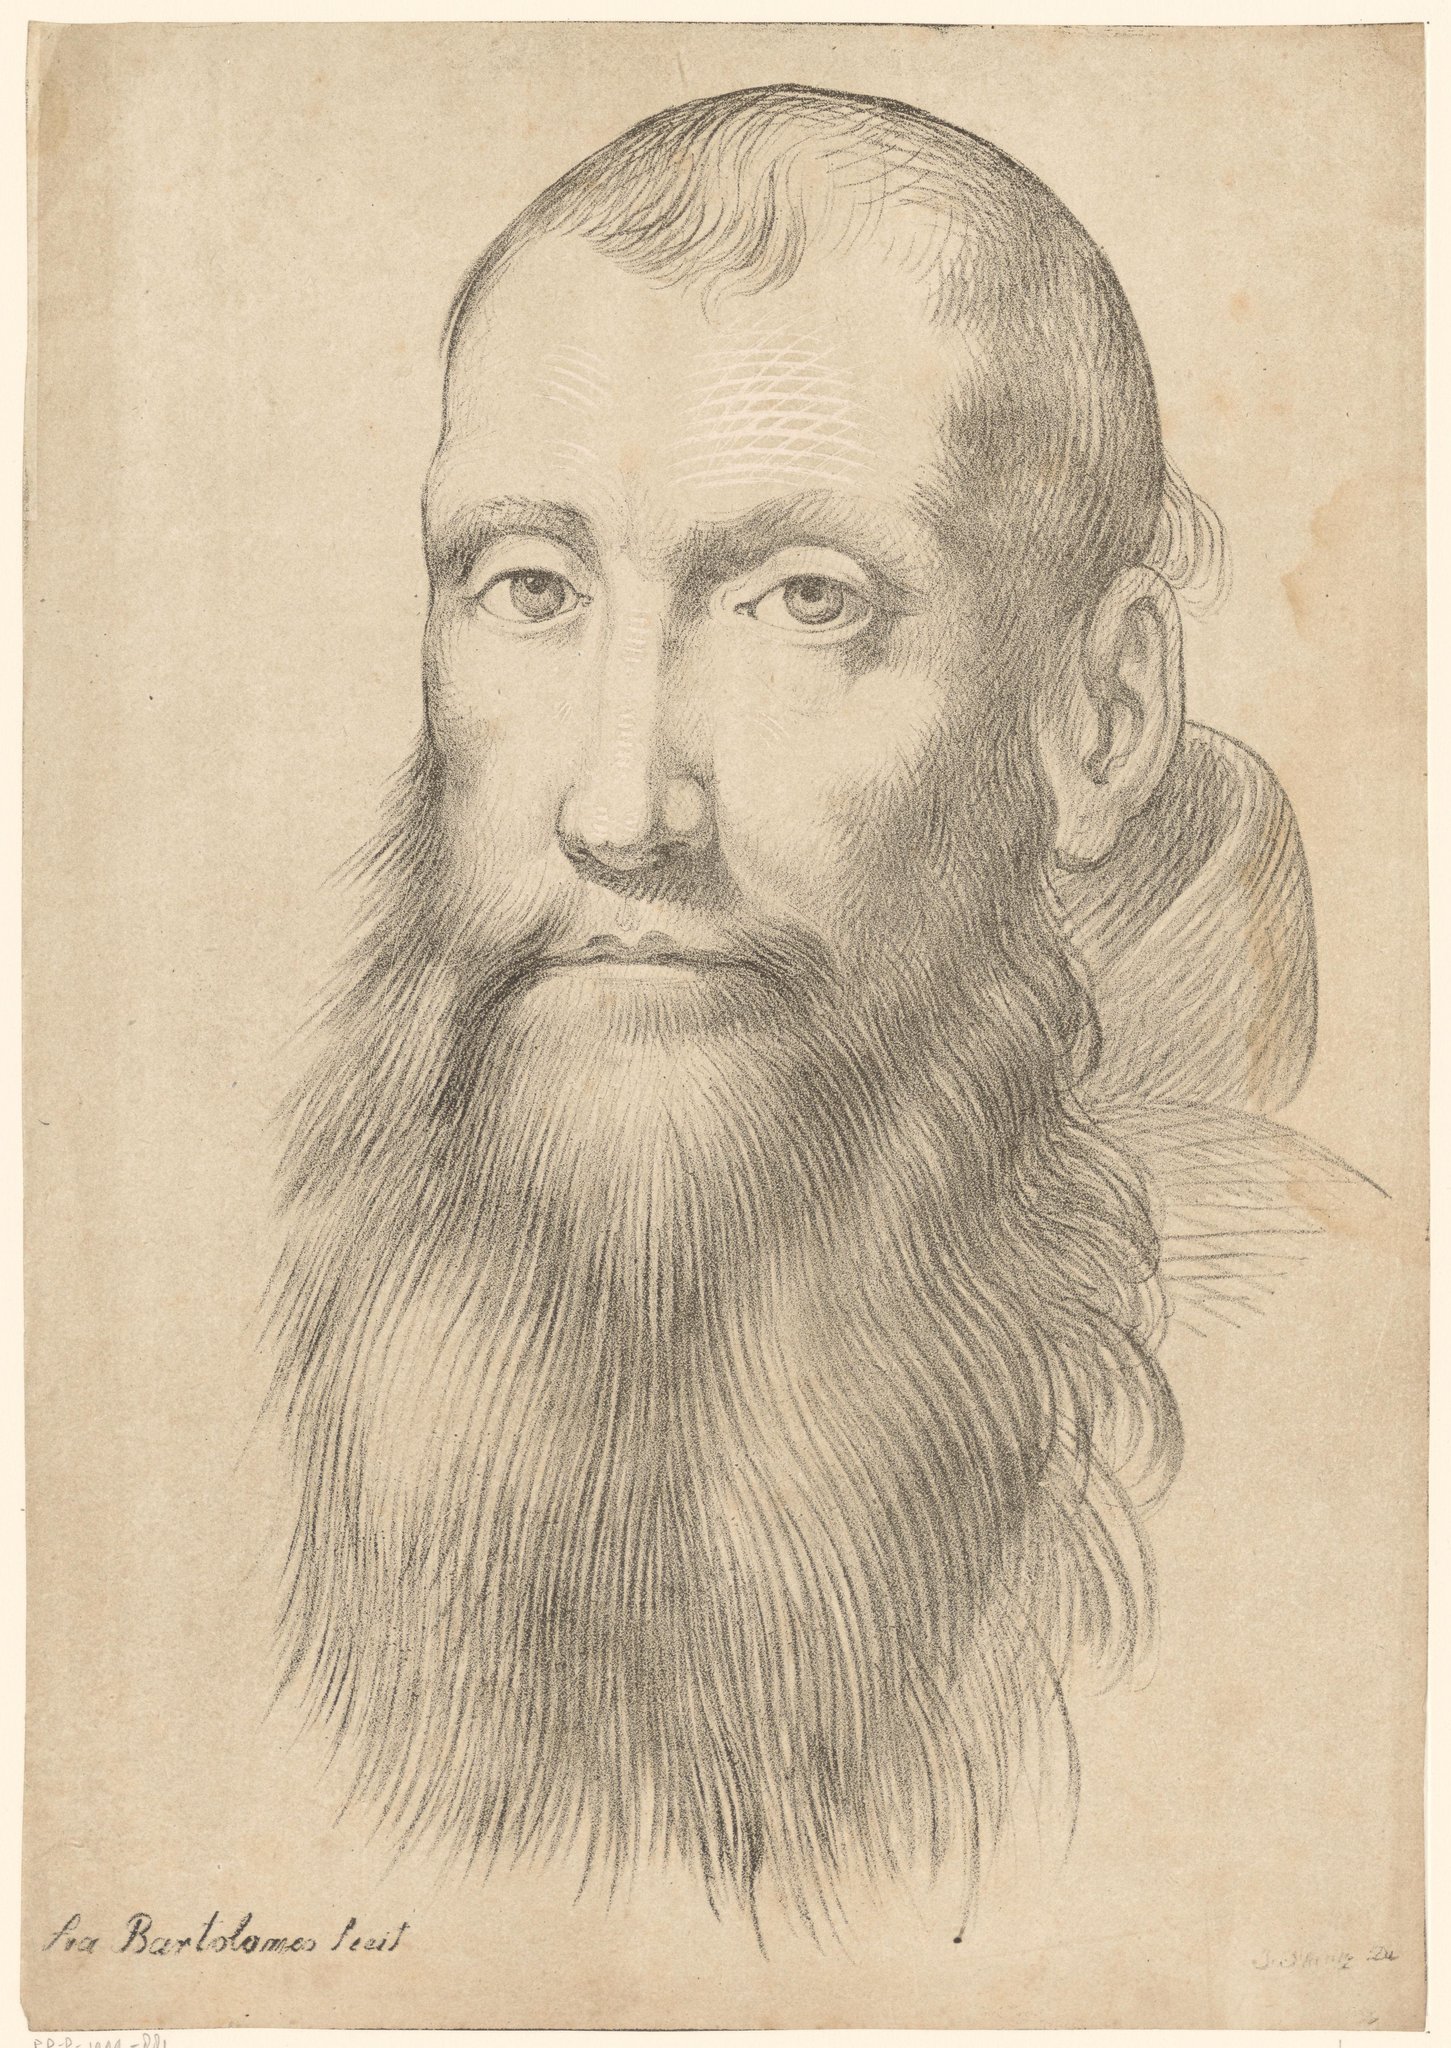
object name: print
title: Hoofd van een man met lange baard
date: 1800-1899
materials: paper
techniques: tone lithography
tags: moustache, adult man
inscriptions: collector's mark: Lugt 2228, mark, collector's mark: Lugt 2760